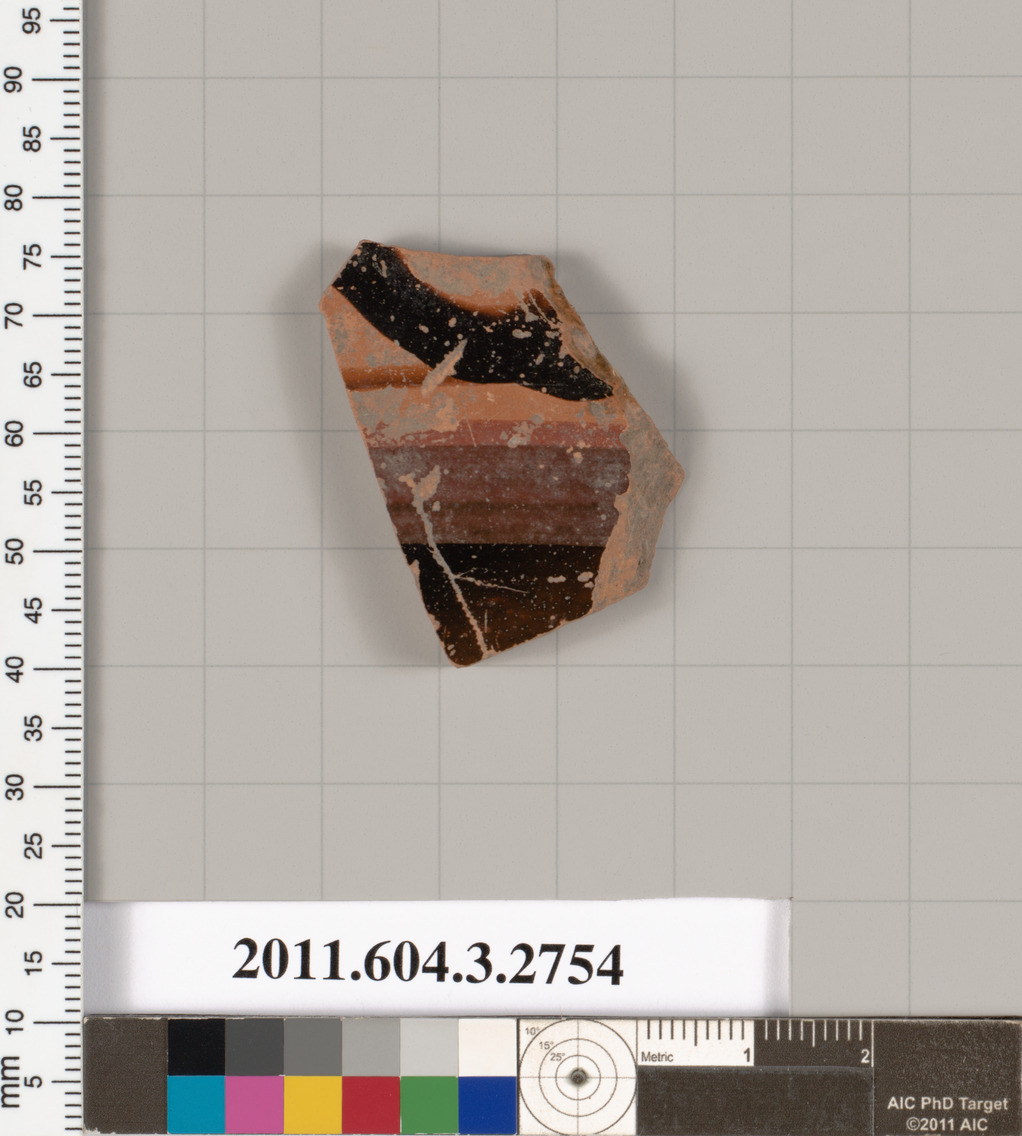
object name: undetermined closed shape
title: Terracotta fragment of a closed shape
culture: greek, attic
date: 600-551 BCE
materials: terracotta